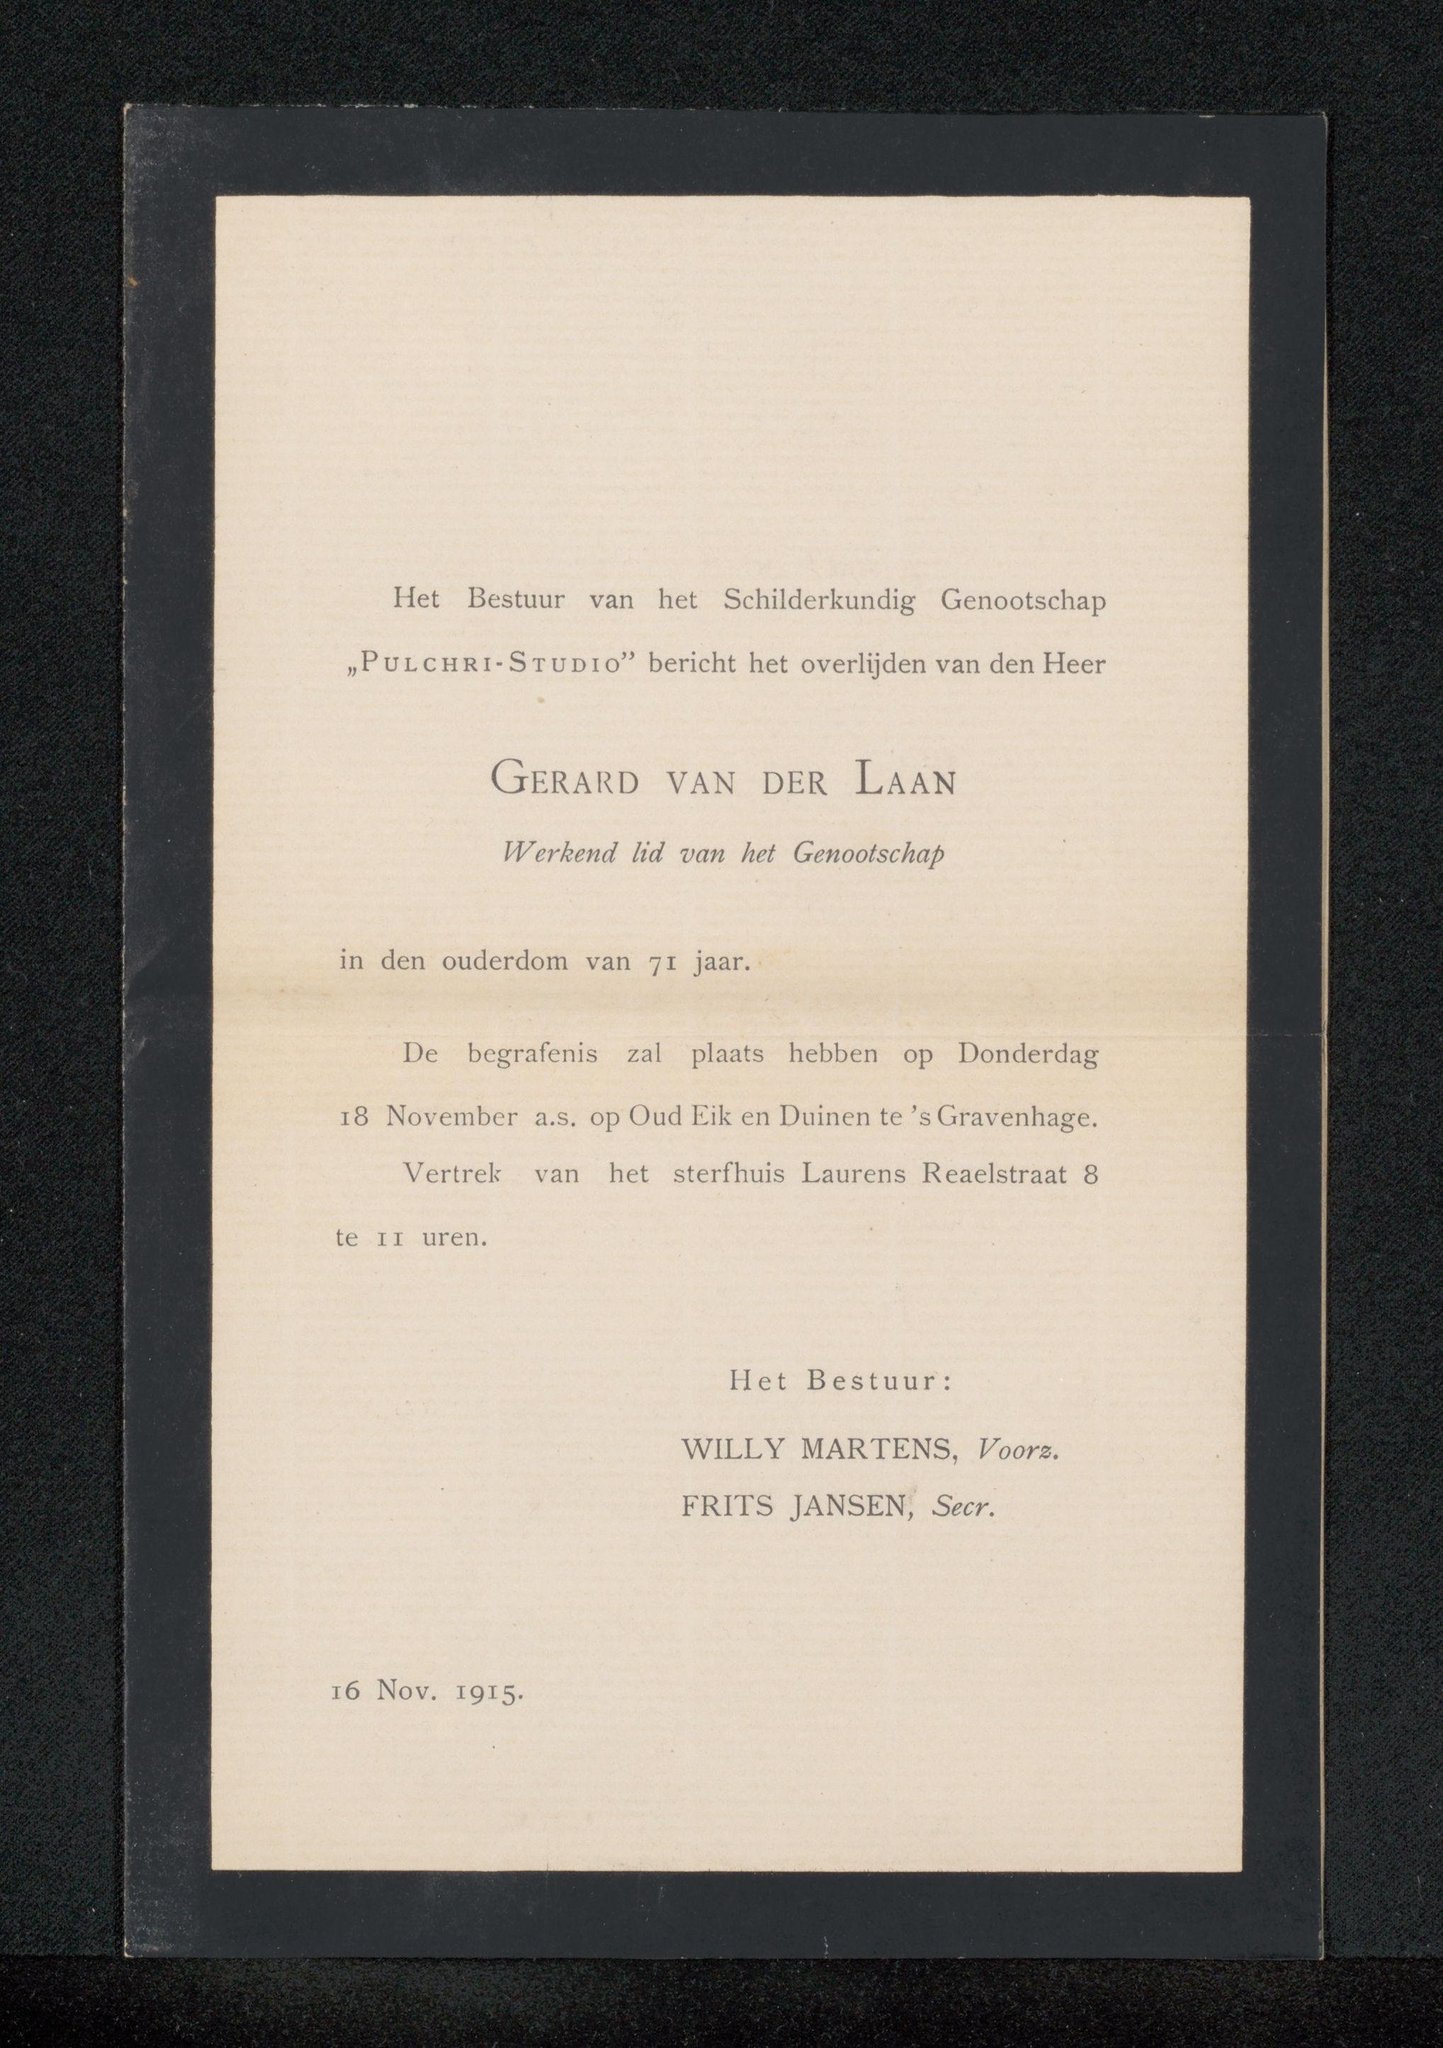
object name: overlijdensbericht, overlijdensadvertentie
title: Overlijdensbericht aan Philip Zilcken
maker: frits jansen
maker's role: painter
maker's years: 1856-1928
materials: ink, paper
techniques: pen, printing, writing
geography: the hague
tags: gerard van der laan, painter, draughtsman, philip zilcken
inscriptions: collector's mark: ‘RPK’